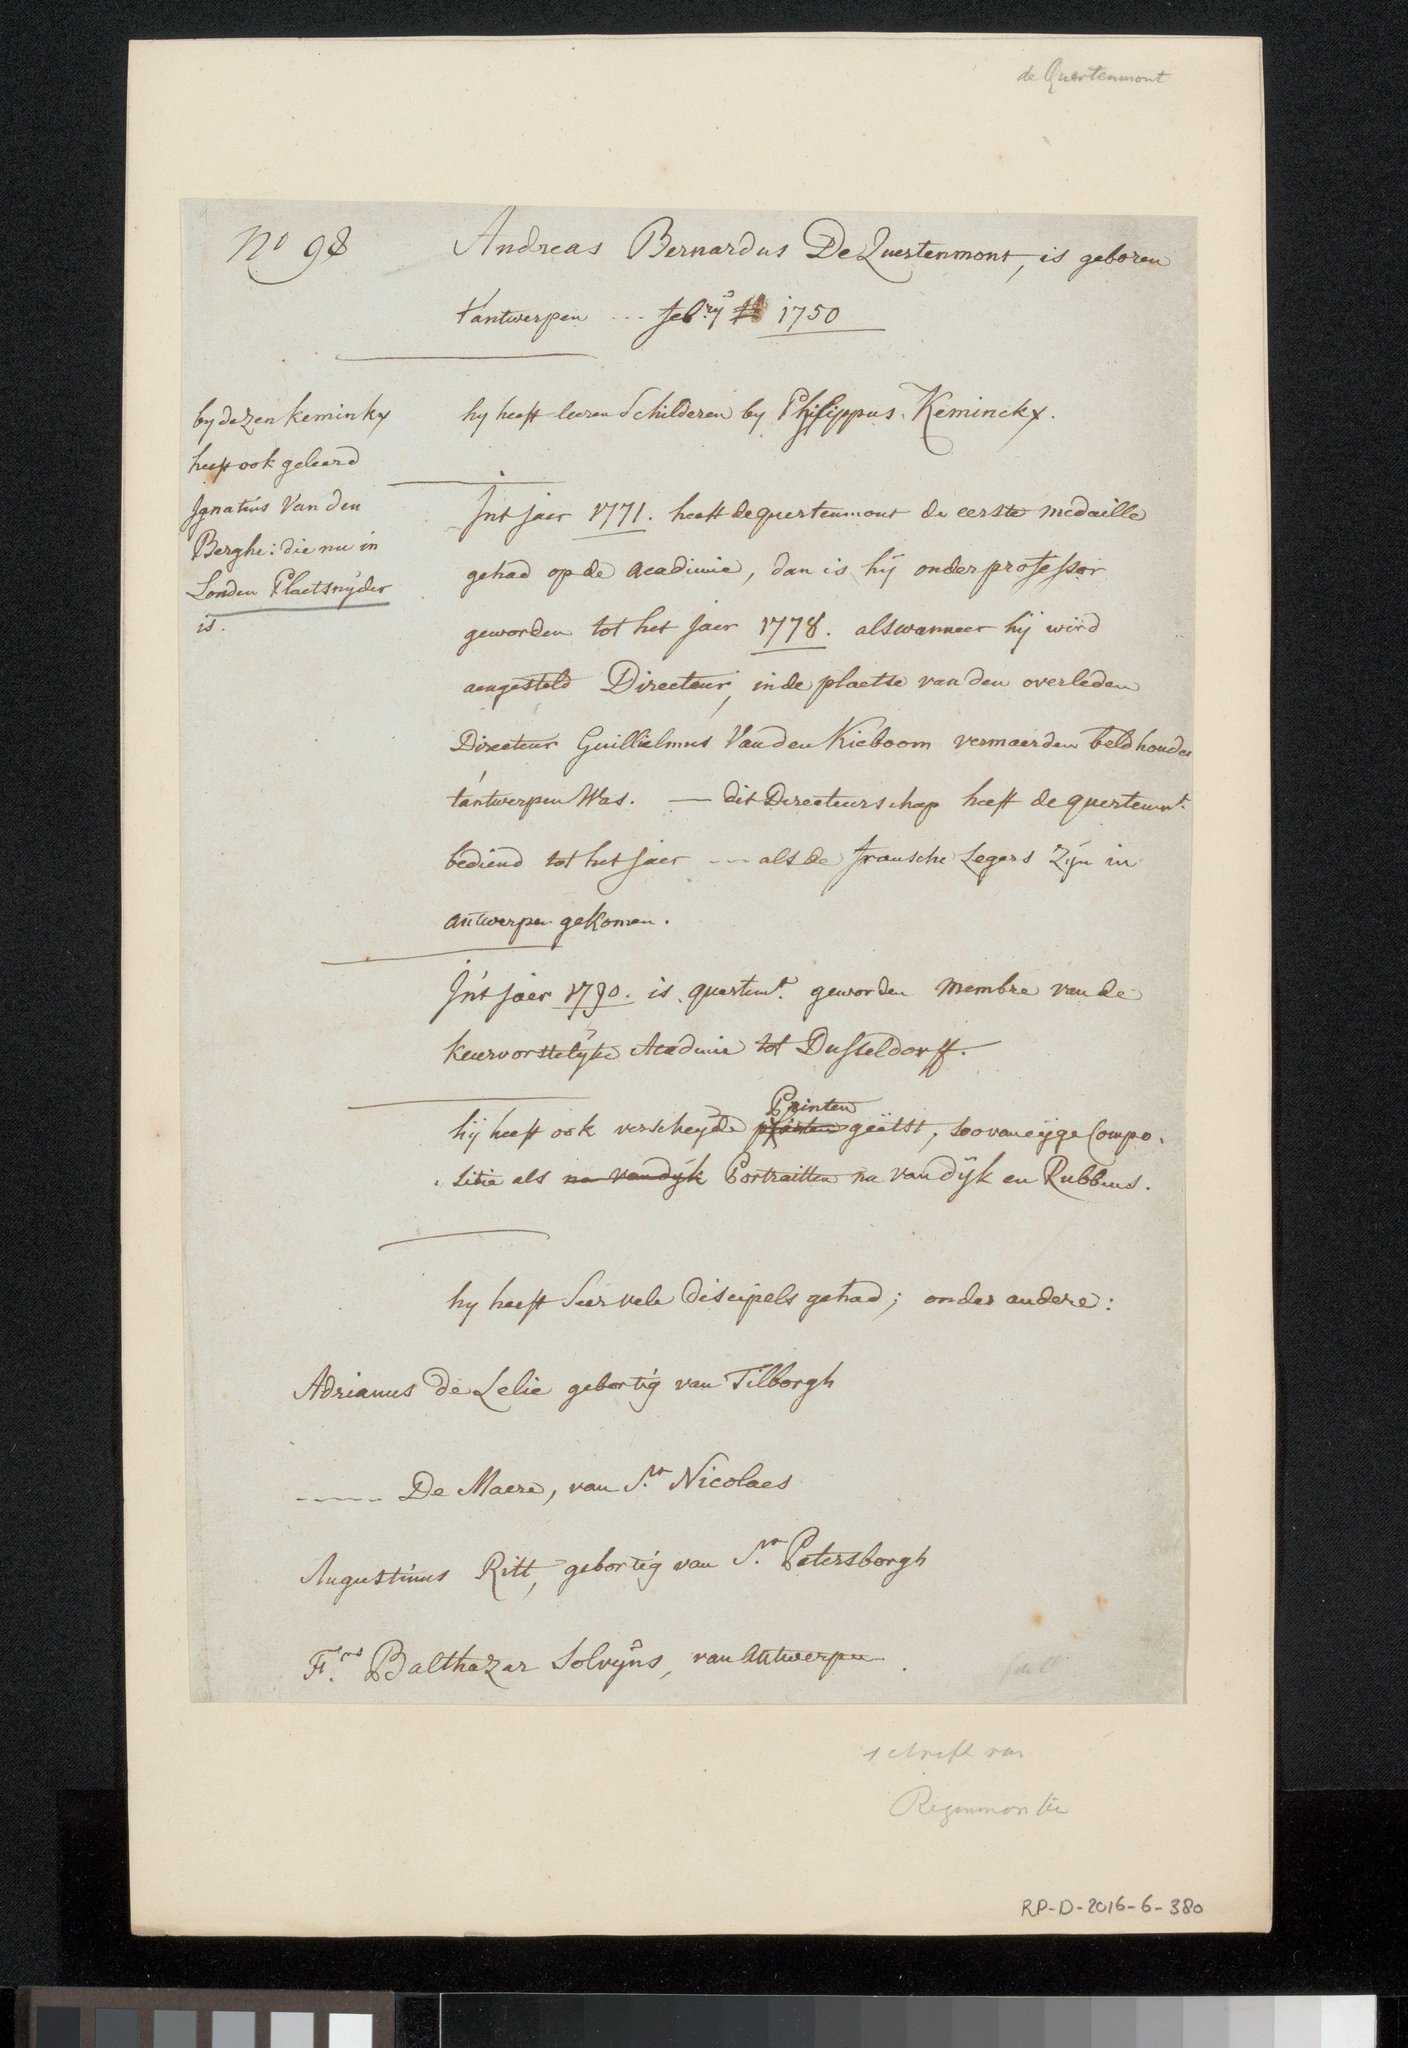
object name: manuscript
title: Handschrift betreffende Andreas Bernardus de Quertenmont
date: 1840-1841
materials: ink, paper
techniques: pen, writing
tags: antwerp, print maker, draughtsman, andreas bernardus de quertenmont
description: Opgenomen in: Immerzeel, J. Jr., De levens en werken der Hollandsche en Vlaamsche kunstschilders, beeldhouwers, graveurs en bouwmeesters, van het begin der vijftiende eeuw tot heden, Amsterdam: J.C. van Kesteren, 1842-1843.